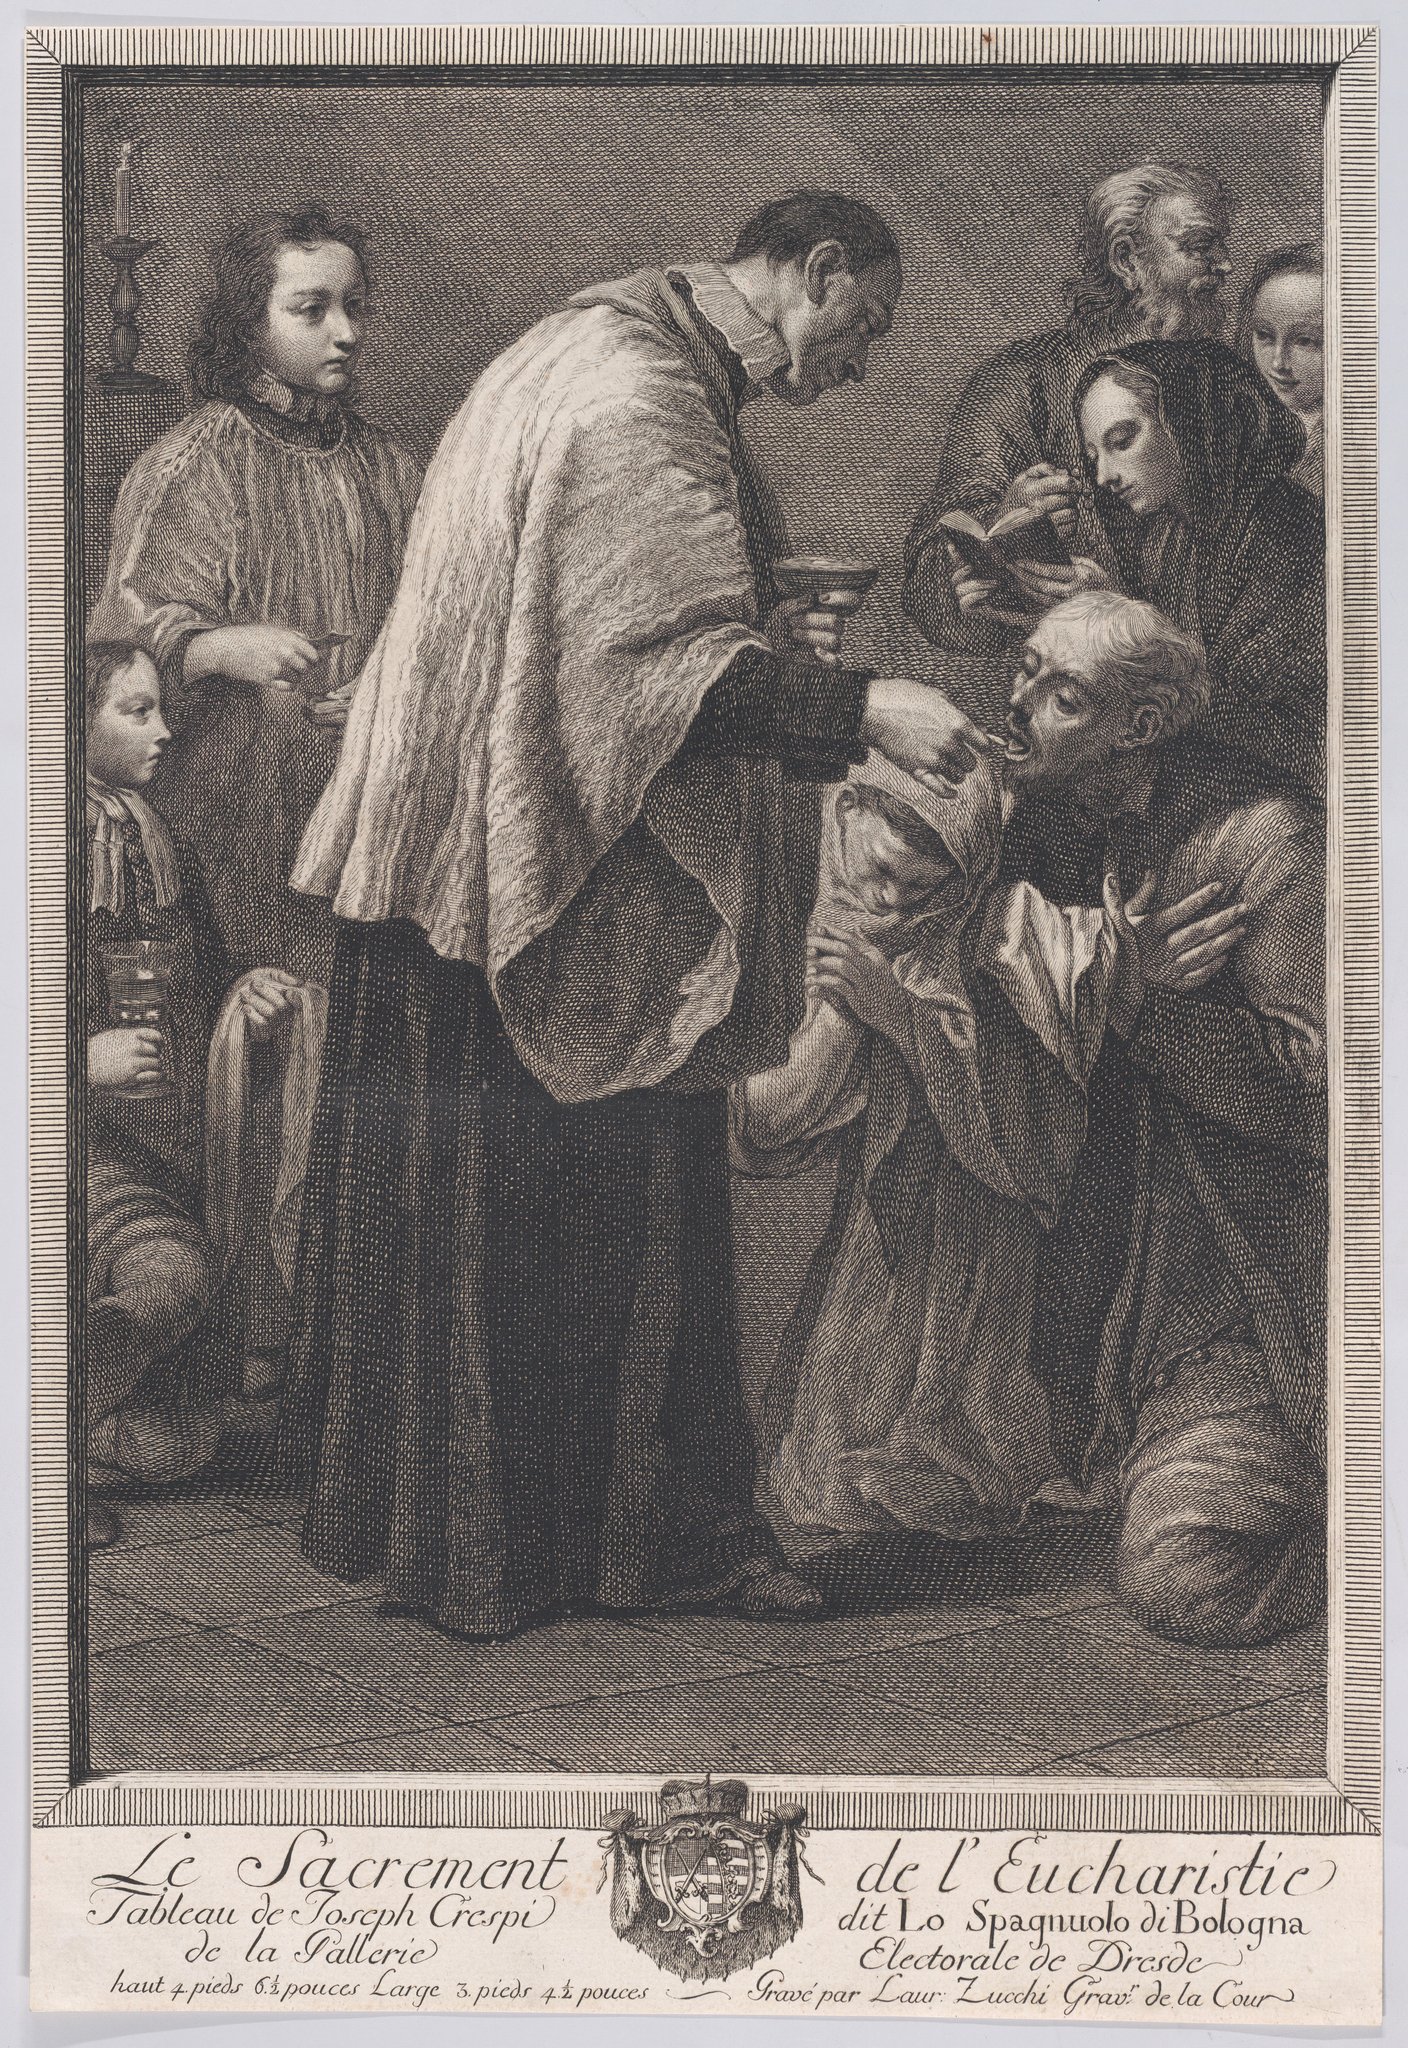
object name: print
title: The Eucharist, from "The Seven Sacraments"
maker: lorenzo zucchi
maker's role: artist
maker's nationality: italian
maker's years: 1704-1779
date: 1767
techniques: etching